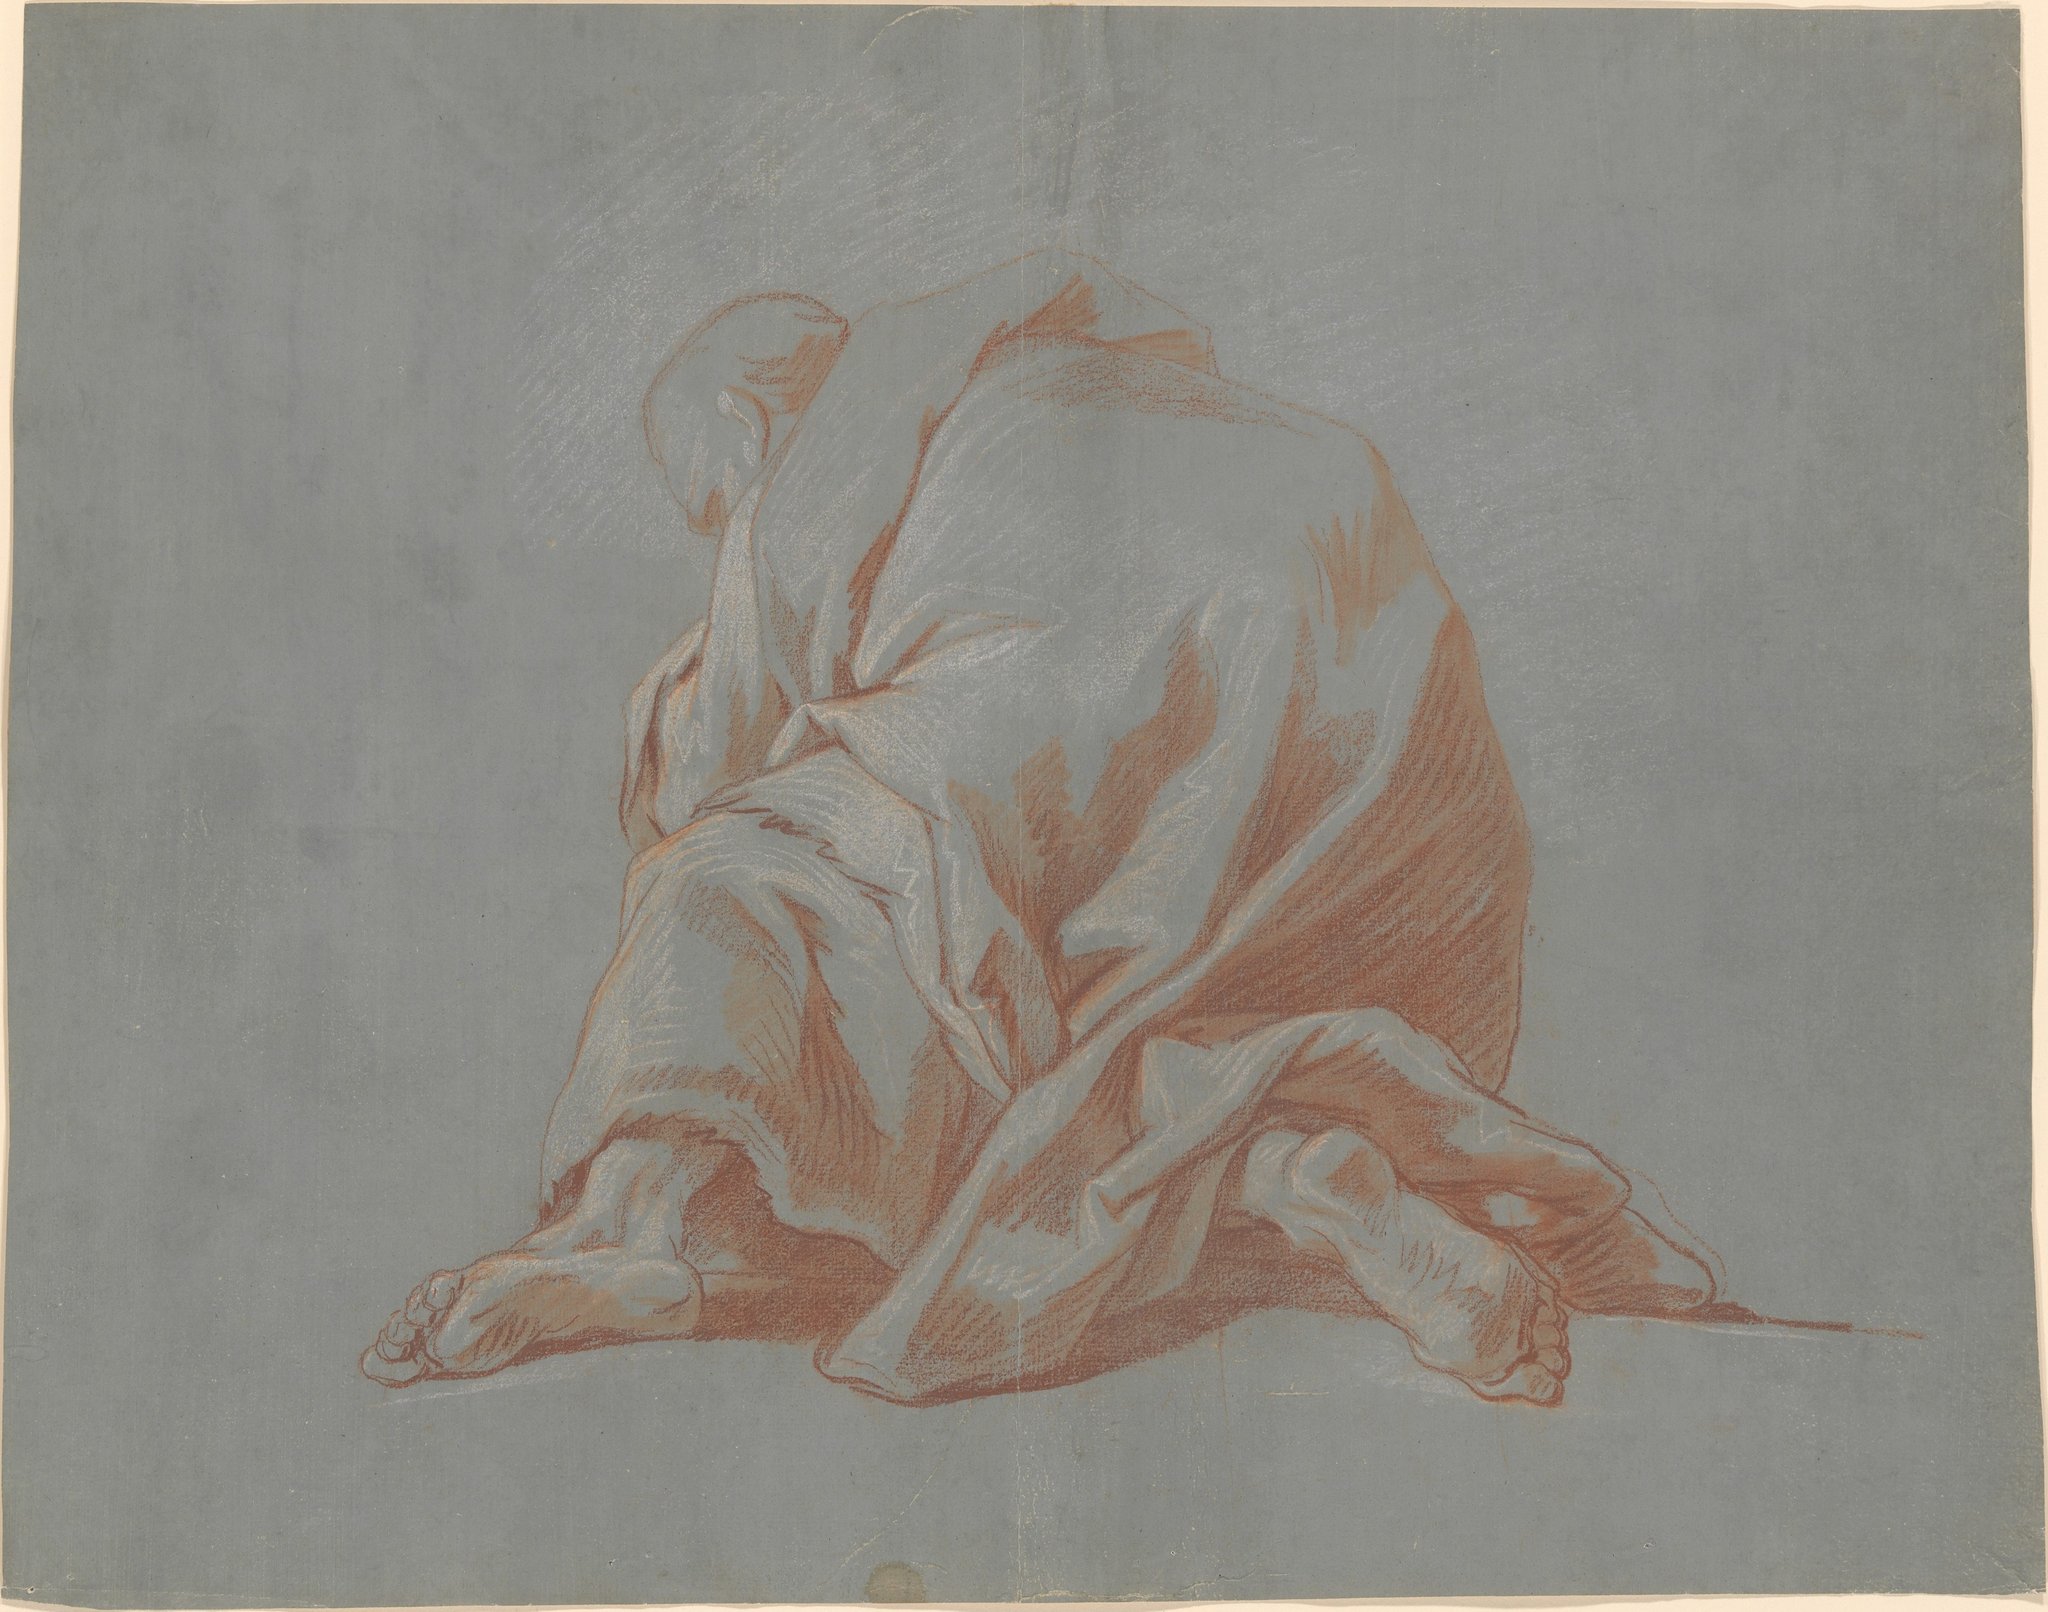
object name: drawing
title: Study of a Draped Figure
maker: jean françois de troy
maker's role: artist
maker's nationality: french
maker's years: 1679-1752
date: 1736-1739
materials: chalk, paper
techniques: stumping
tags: men